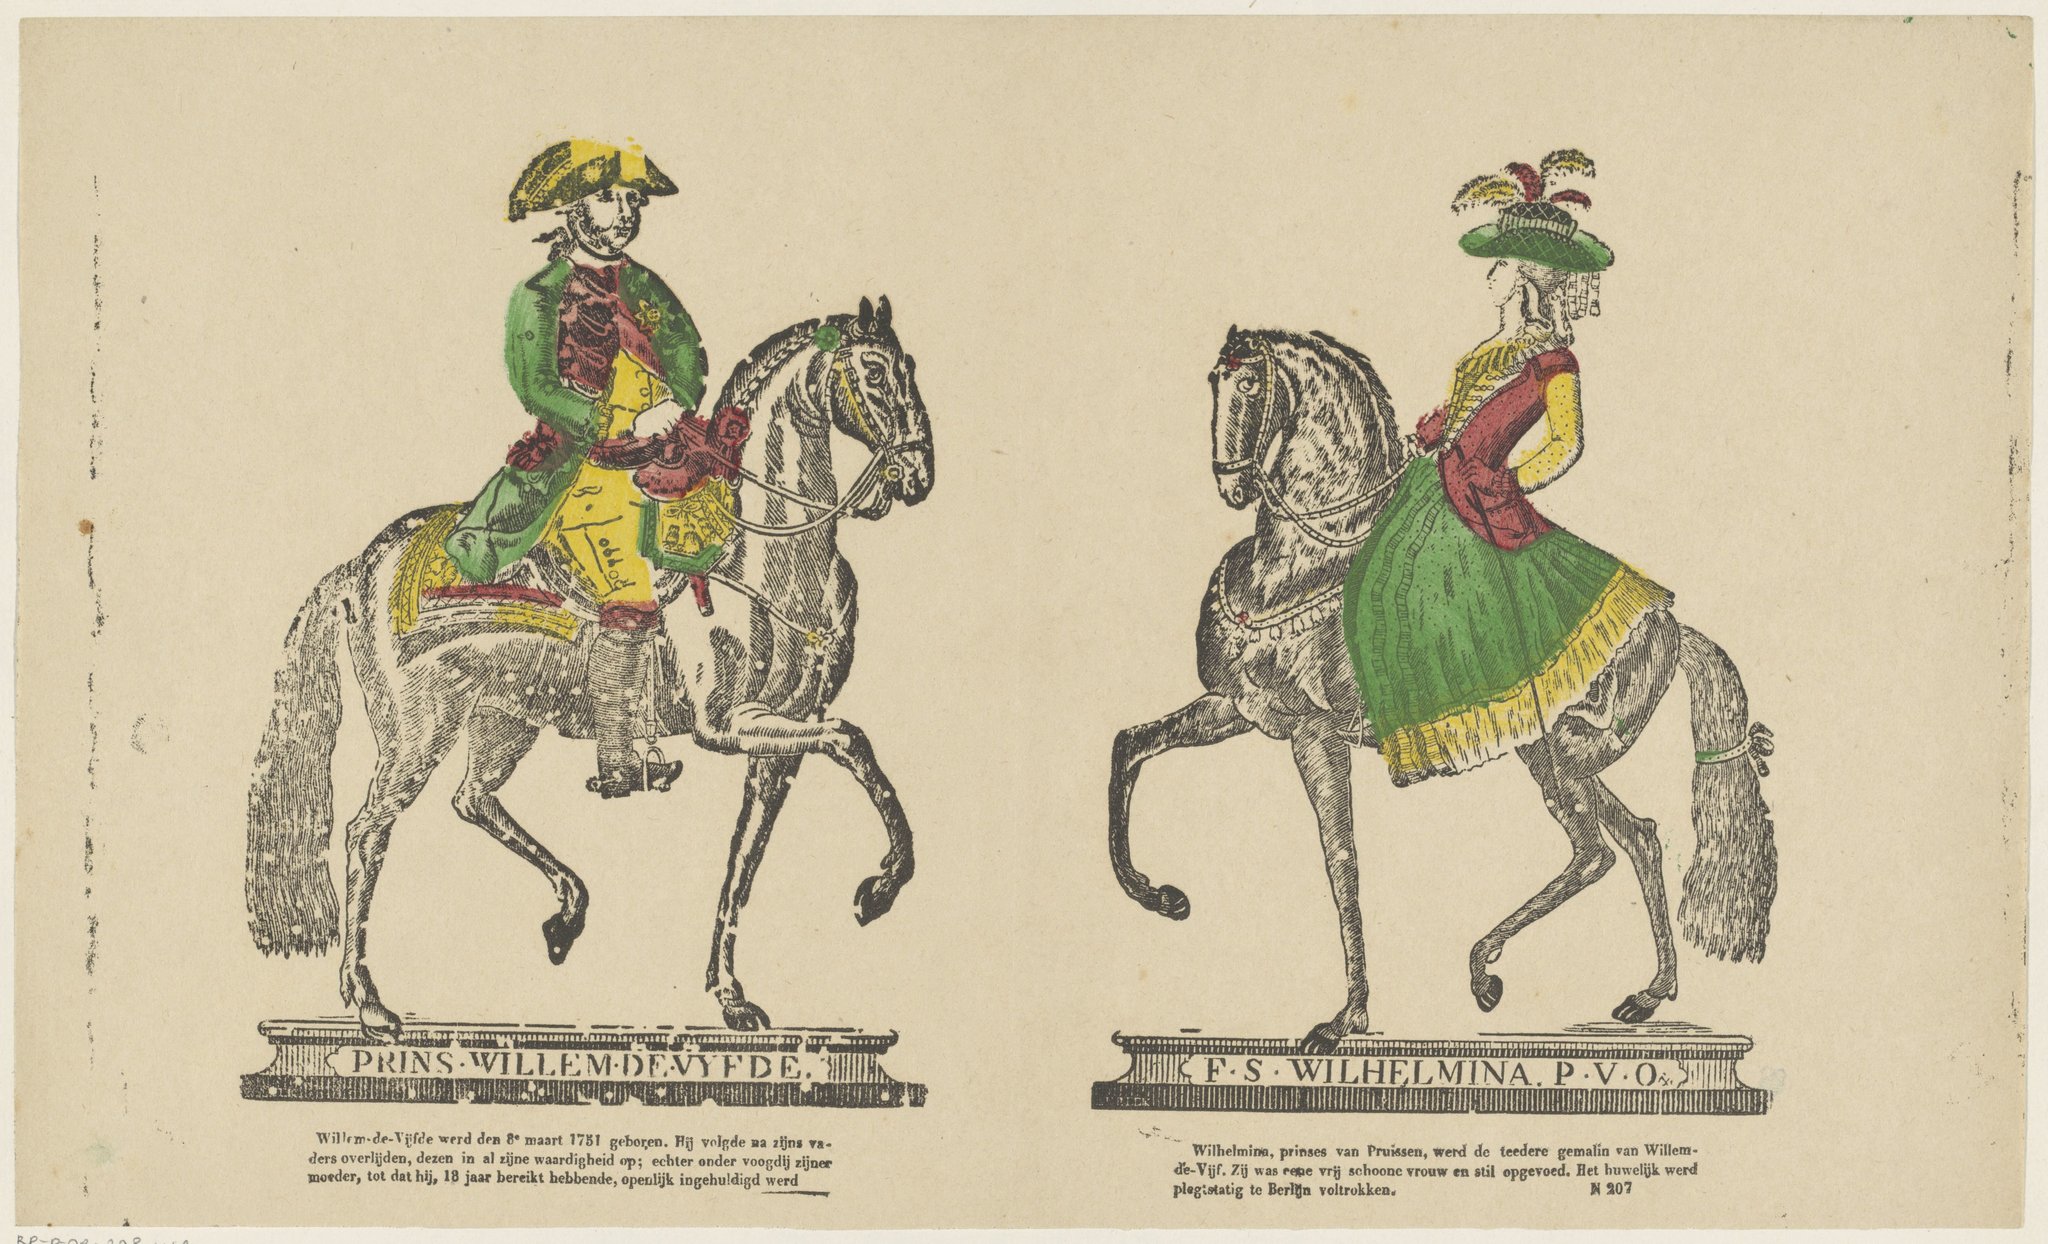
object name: popular print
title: Prins Willem de vyfde / F.S. Wilhelmina P.V.O.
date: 1833-1900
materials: paper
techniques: colour, letterpress printing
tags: the hague, william v (prince of orange), wilhelmina of prussia (princess of orange), equestrian state-portrait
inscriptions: collector's mark: Lugt 2760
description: Blad met 2 voorstellingen. Links een ruiterportret van Willem V, rechts een ruiterportret van Wilhelmina van Pruisen. Onder elke afbeelding een onderschrift. Genummerd rechtsonder: N 207.